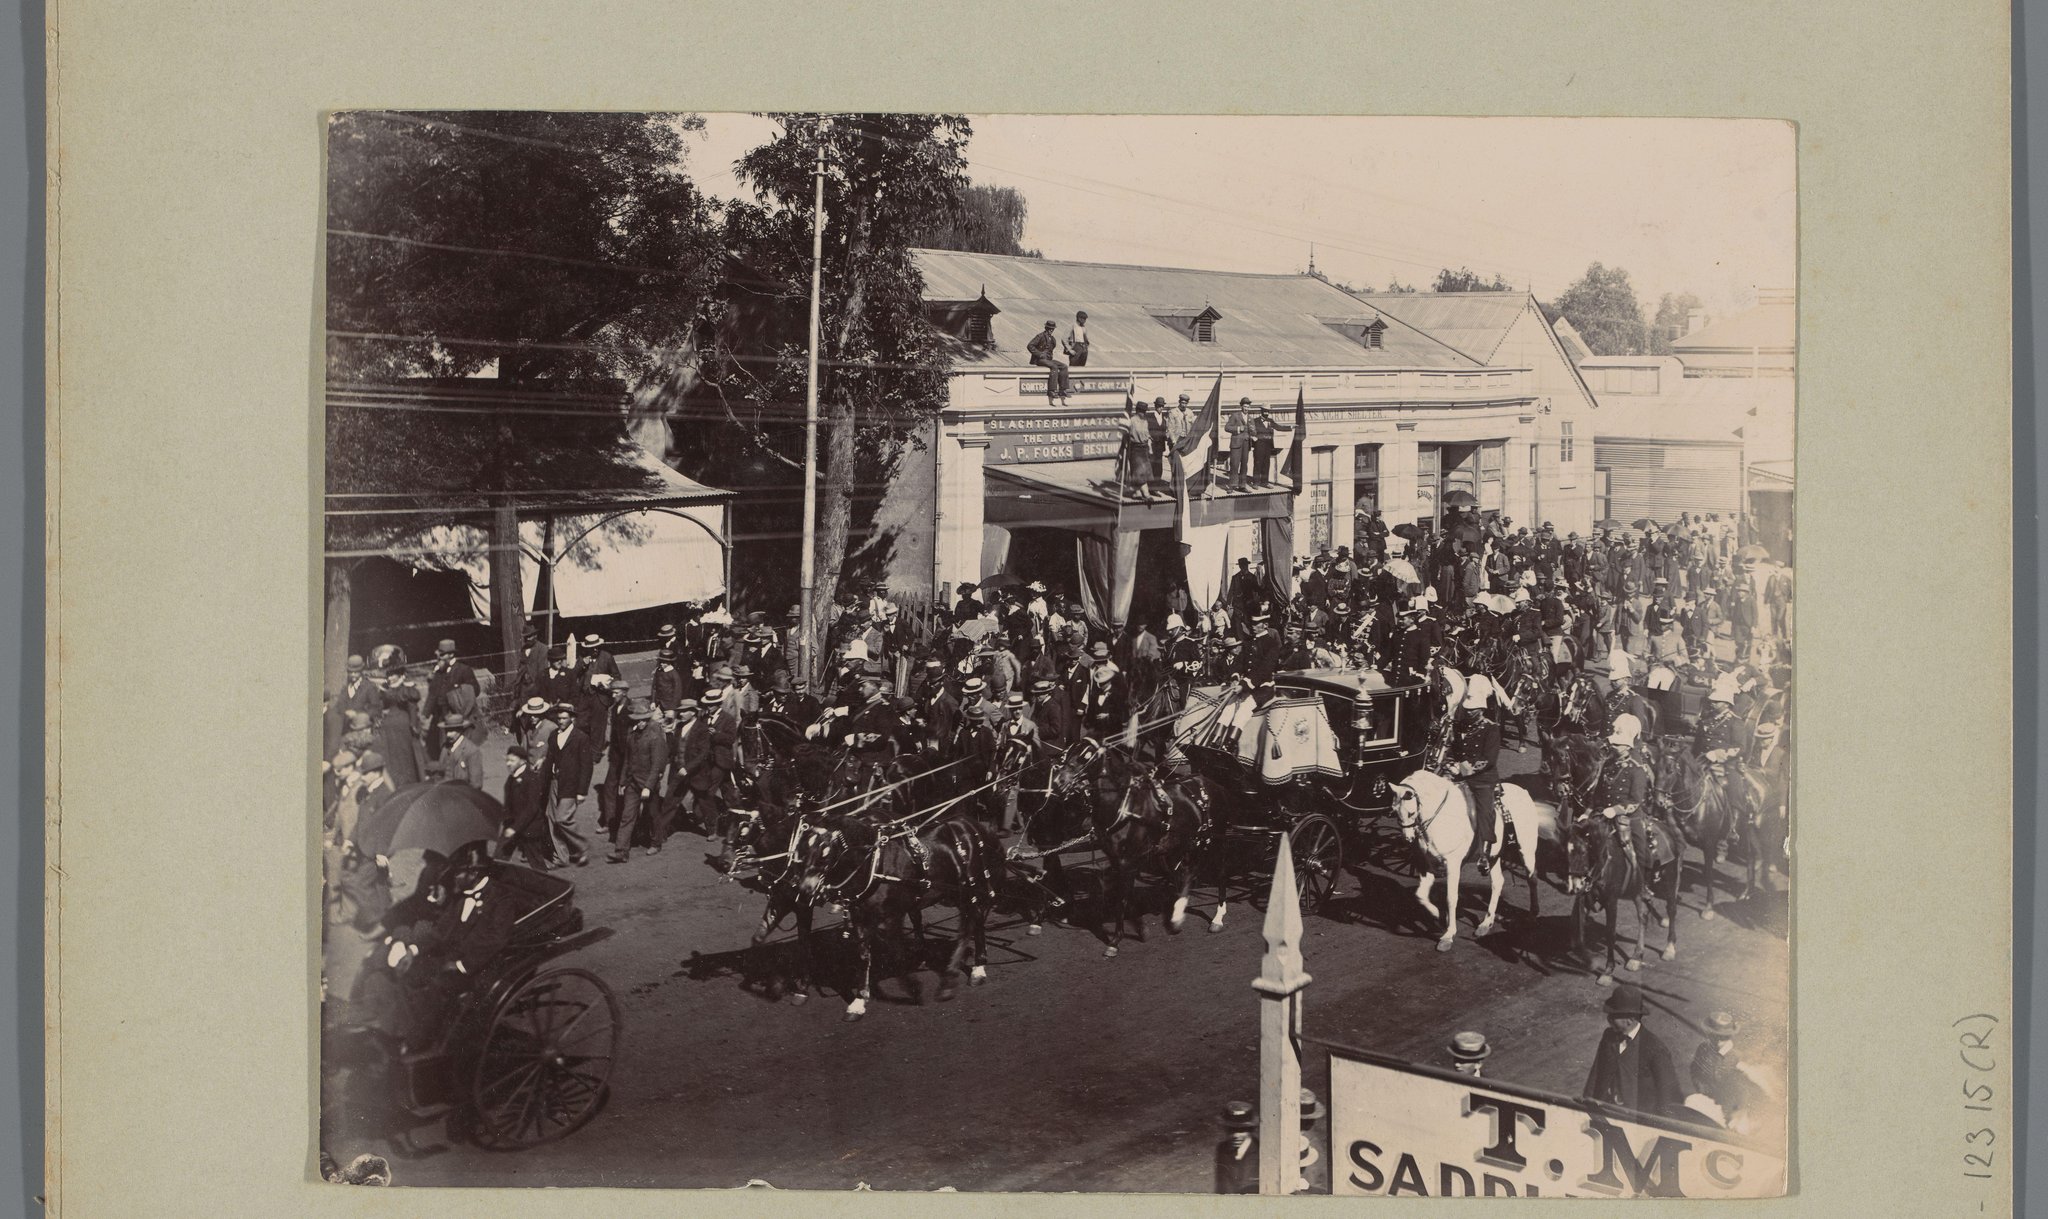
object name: photograph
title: Parade, mogelijk ter ere van de inauguratie van president Kruger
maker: Anonymous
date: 1890-1905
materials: paper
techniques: gelatin silver print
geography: south africa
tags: ceremonial procession, parade, pageant ~ installation of a ruler